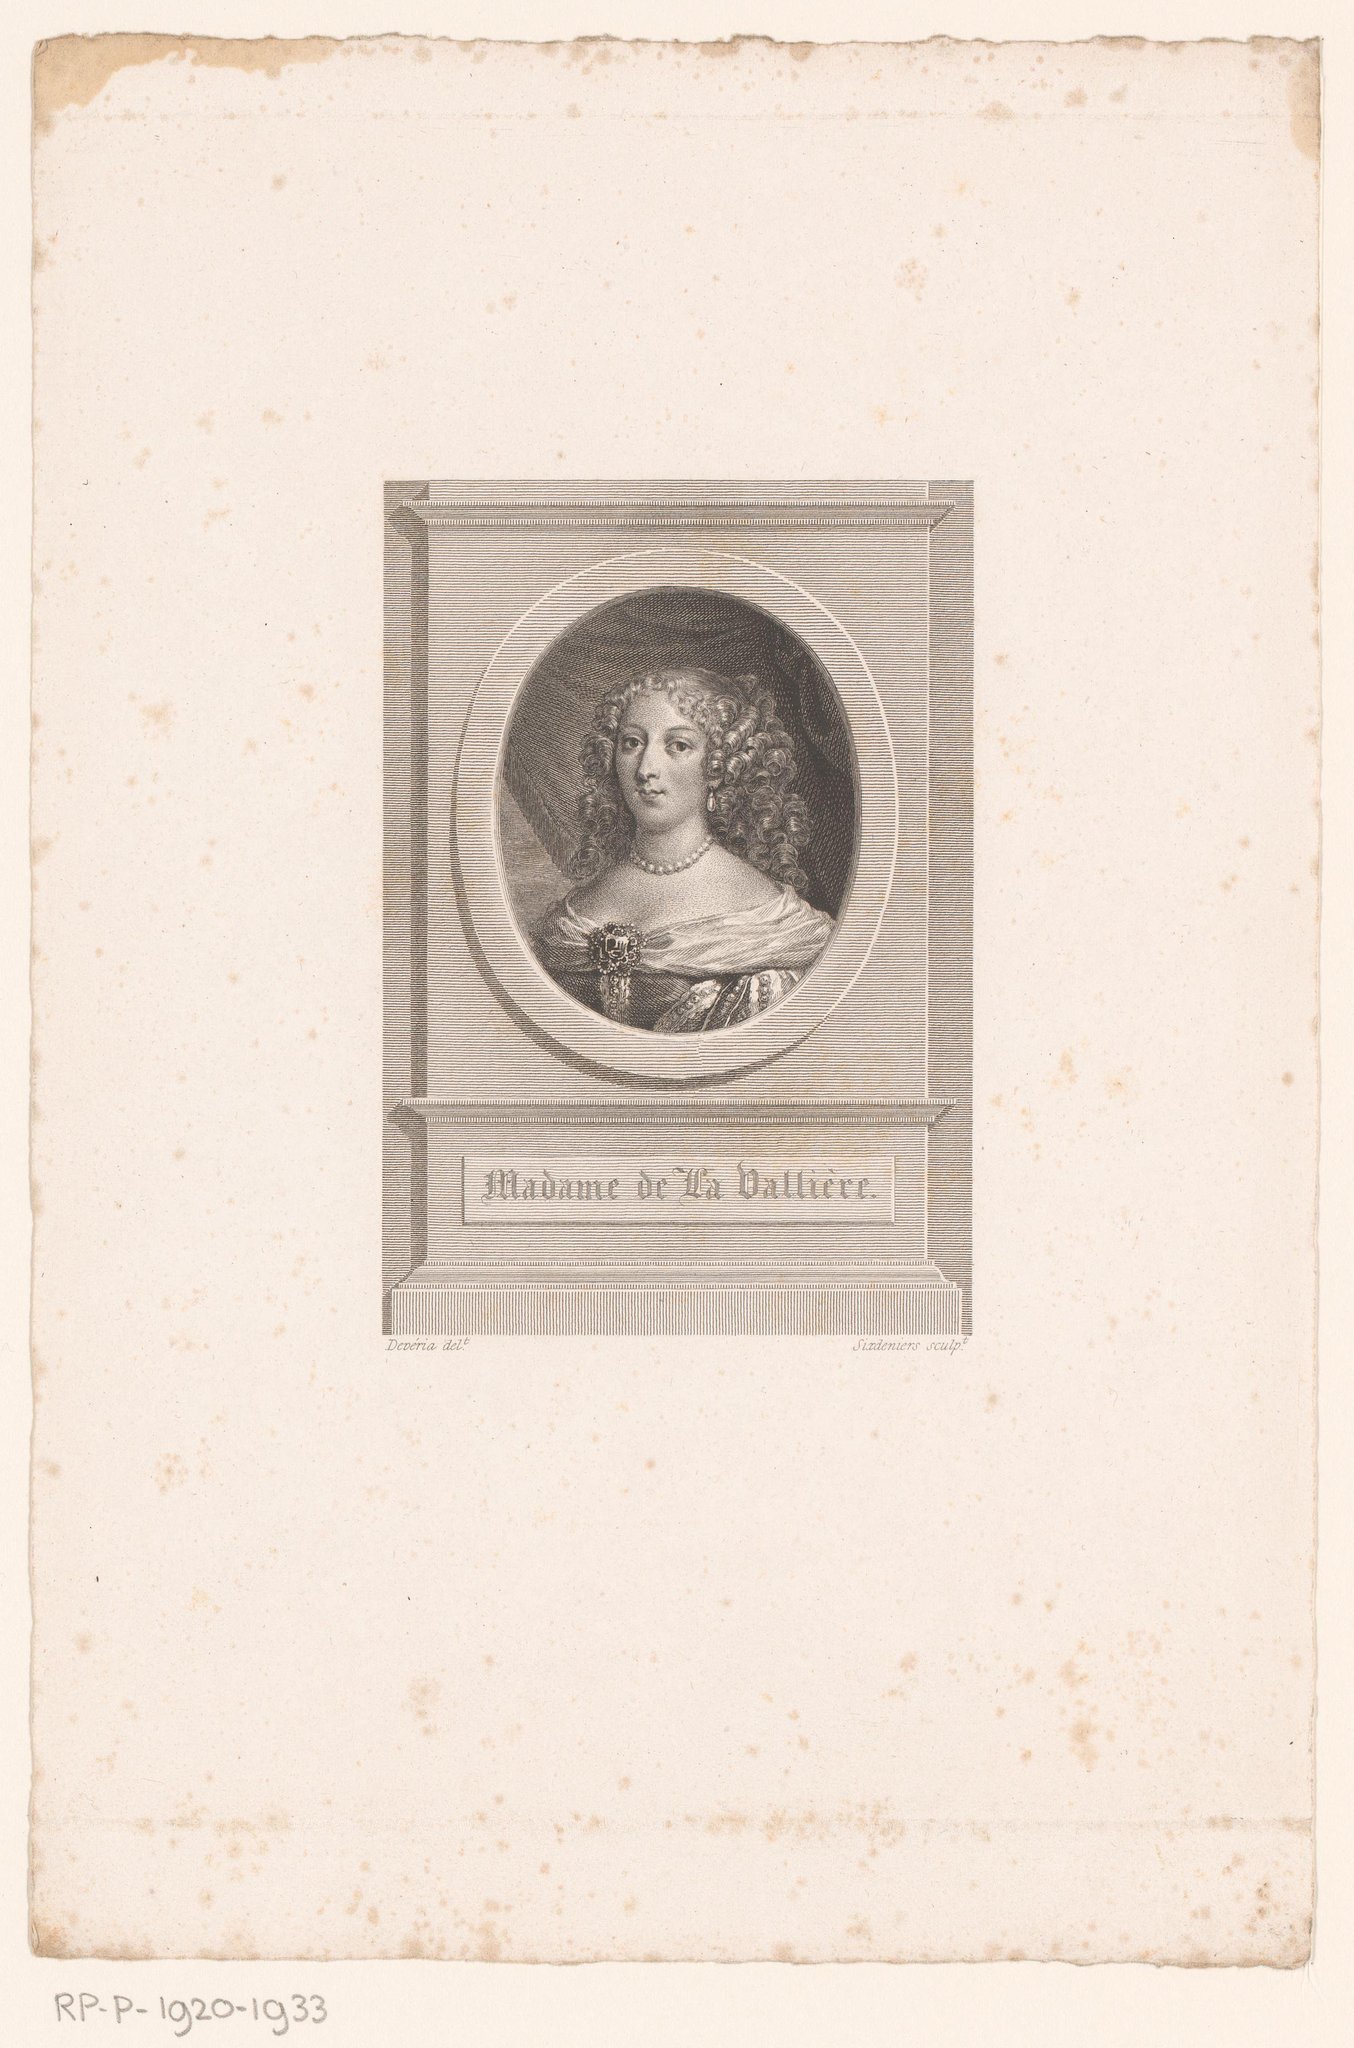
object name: print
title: Portret van Françoise-Louise de La Vallière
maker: alexandre vincent sixdeniers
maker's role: print maker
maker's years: 1793-1846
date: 1803-1846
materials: paper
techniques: engraving, etching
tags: paris, historical persons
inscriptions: collector's mark: Lugt 2228